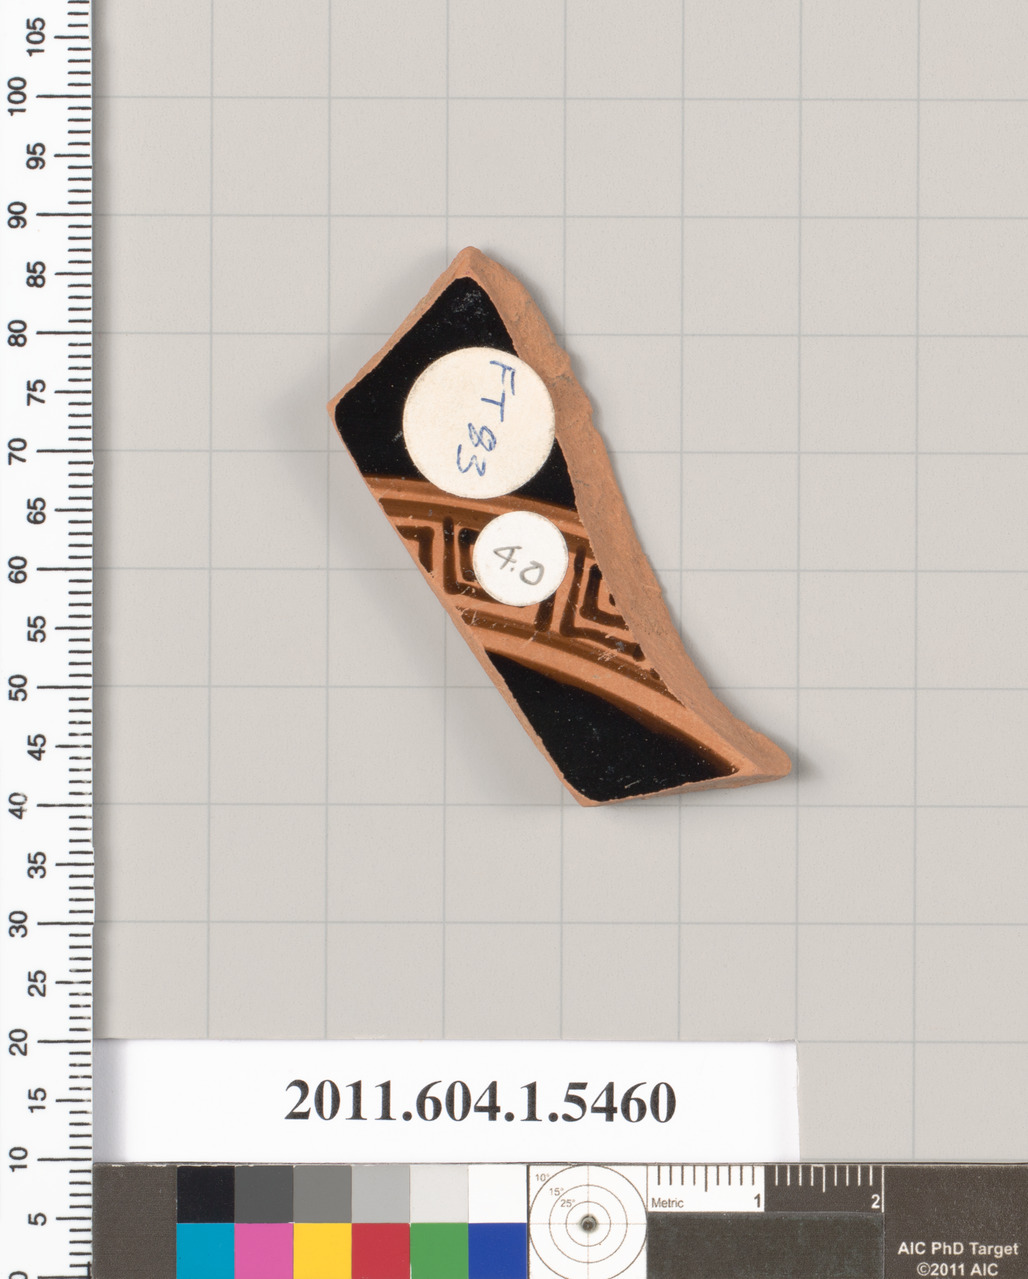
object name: kylix fragment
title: Terracotta fragment of a kylix (drinking cup)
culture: greek, attic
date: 520-500 BCE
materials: terracotta